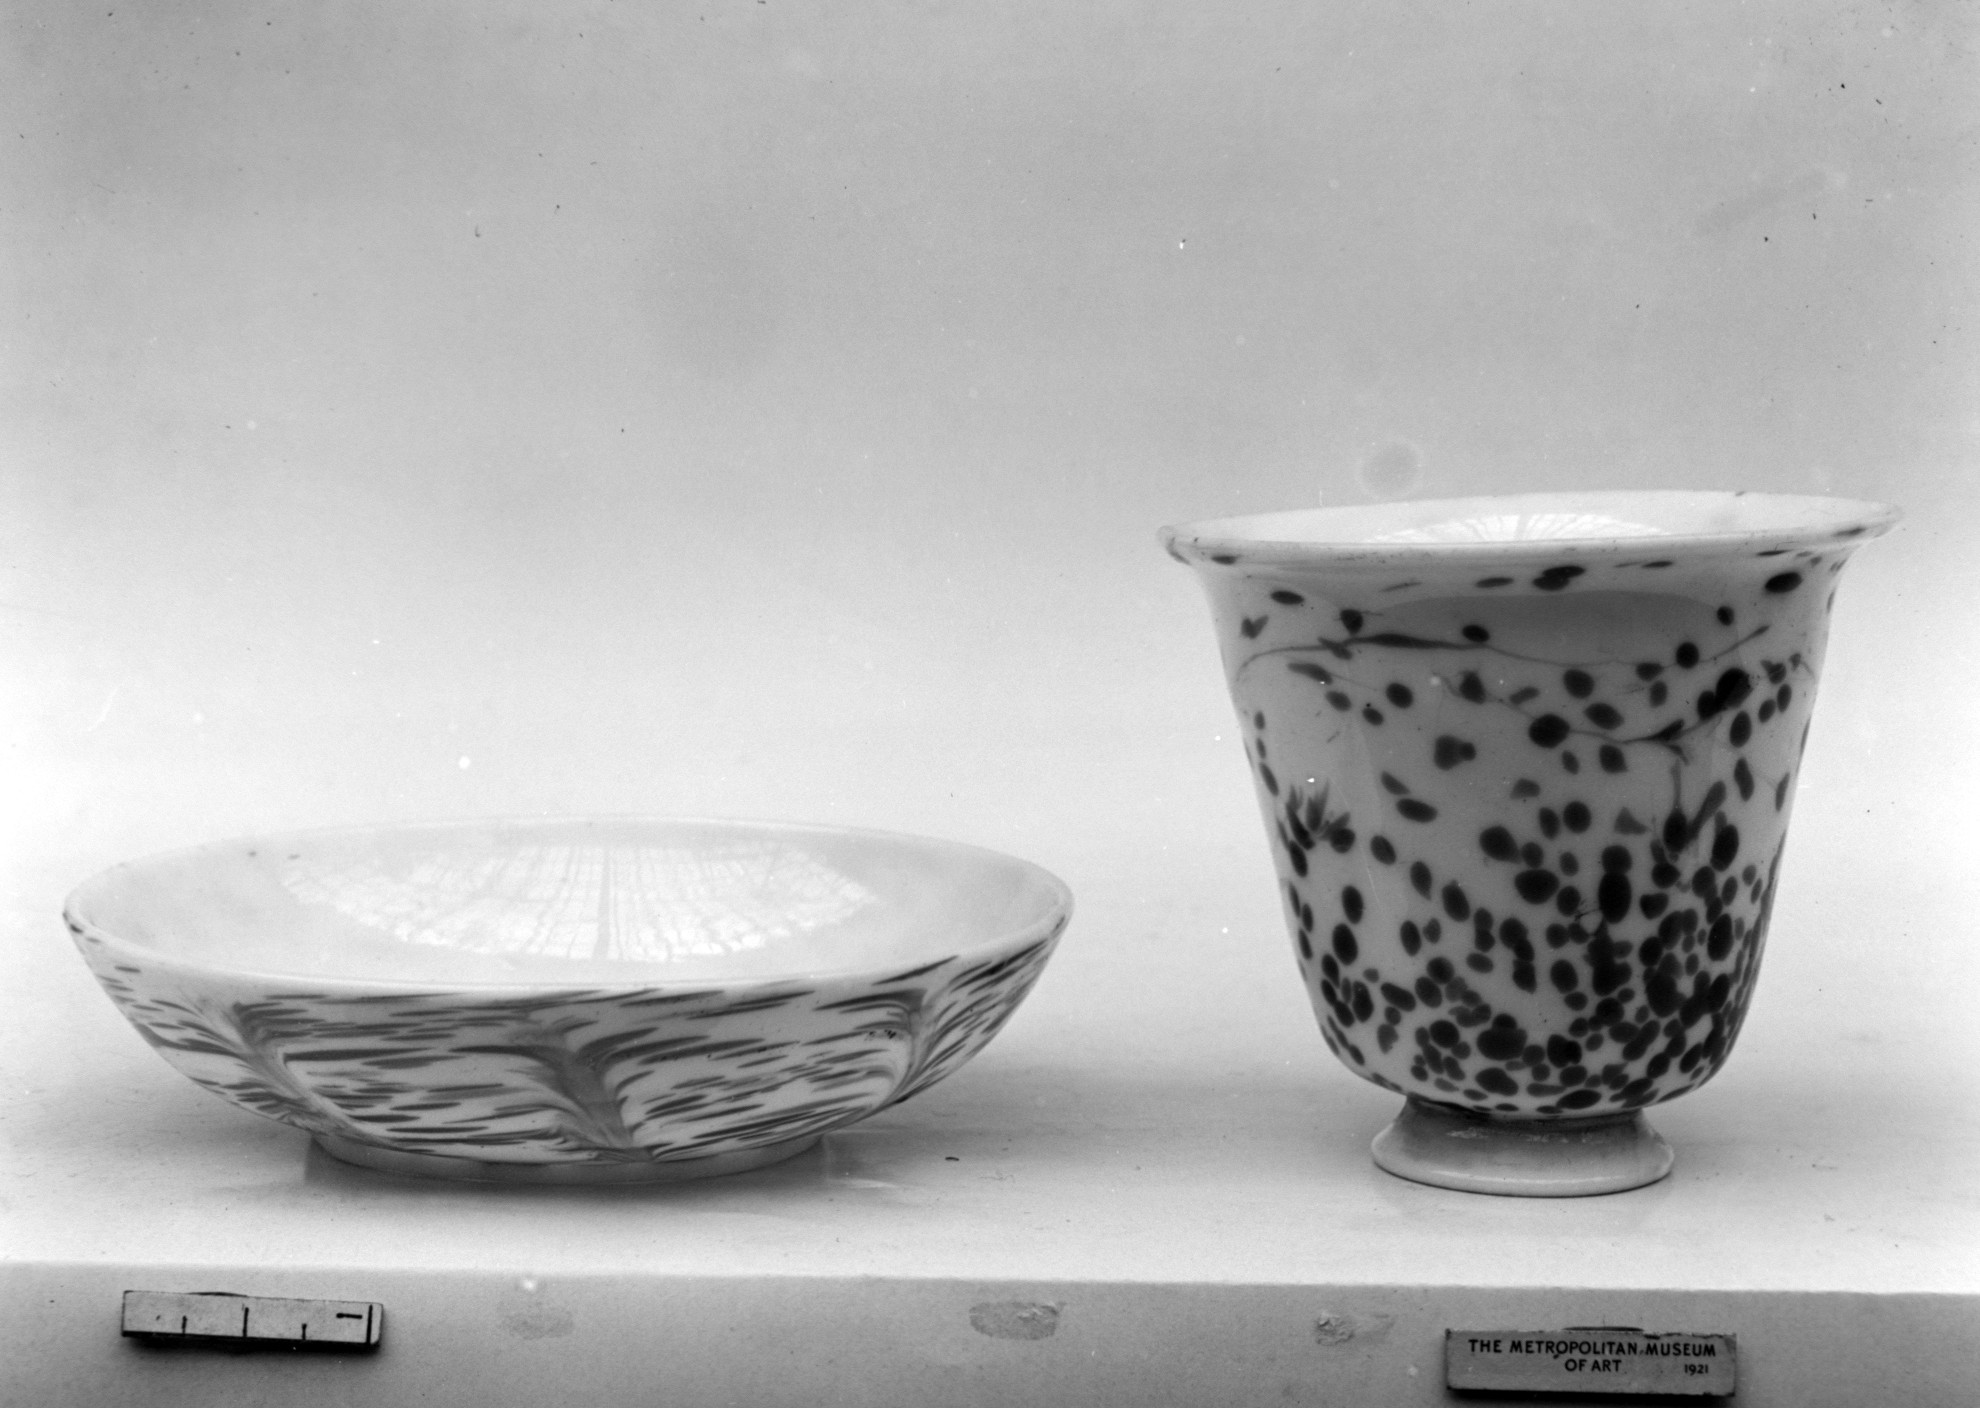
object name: beaker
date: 1701-1750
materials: glass